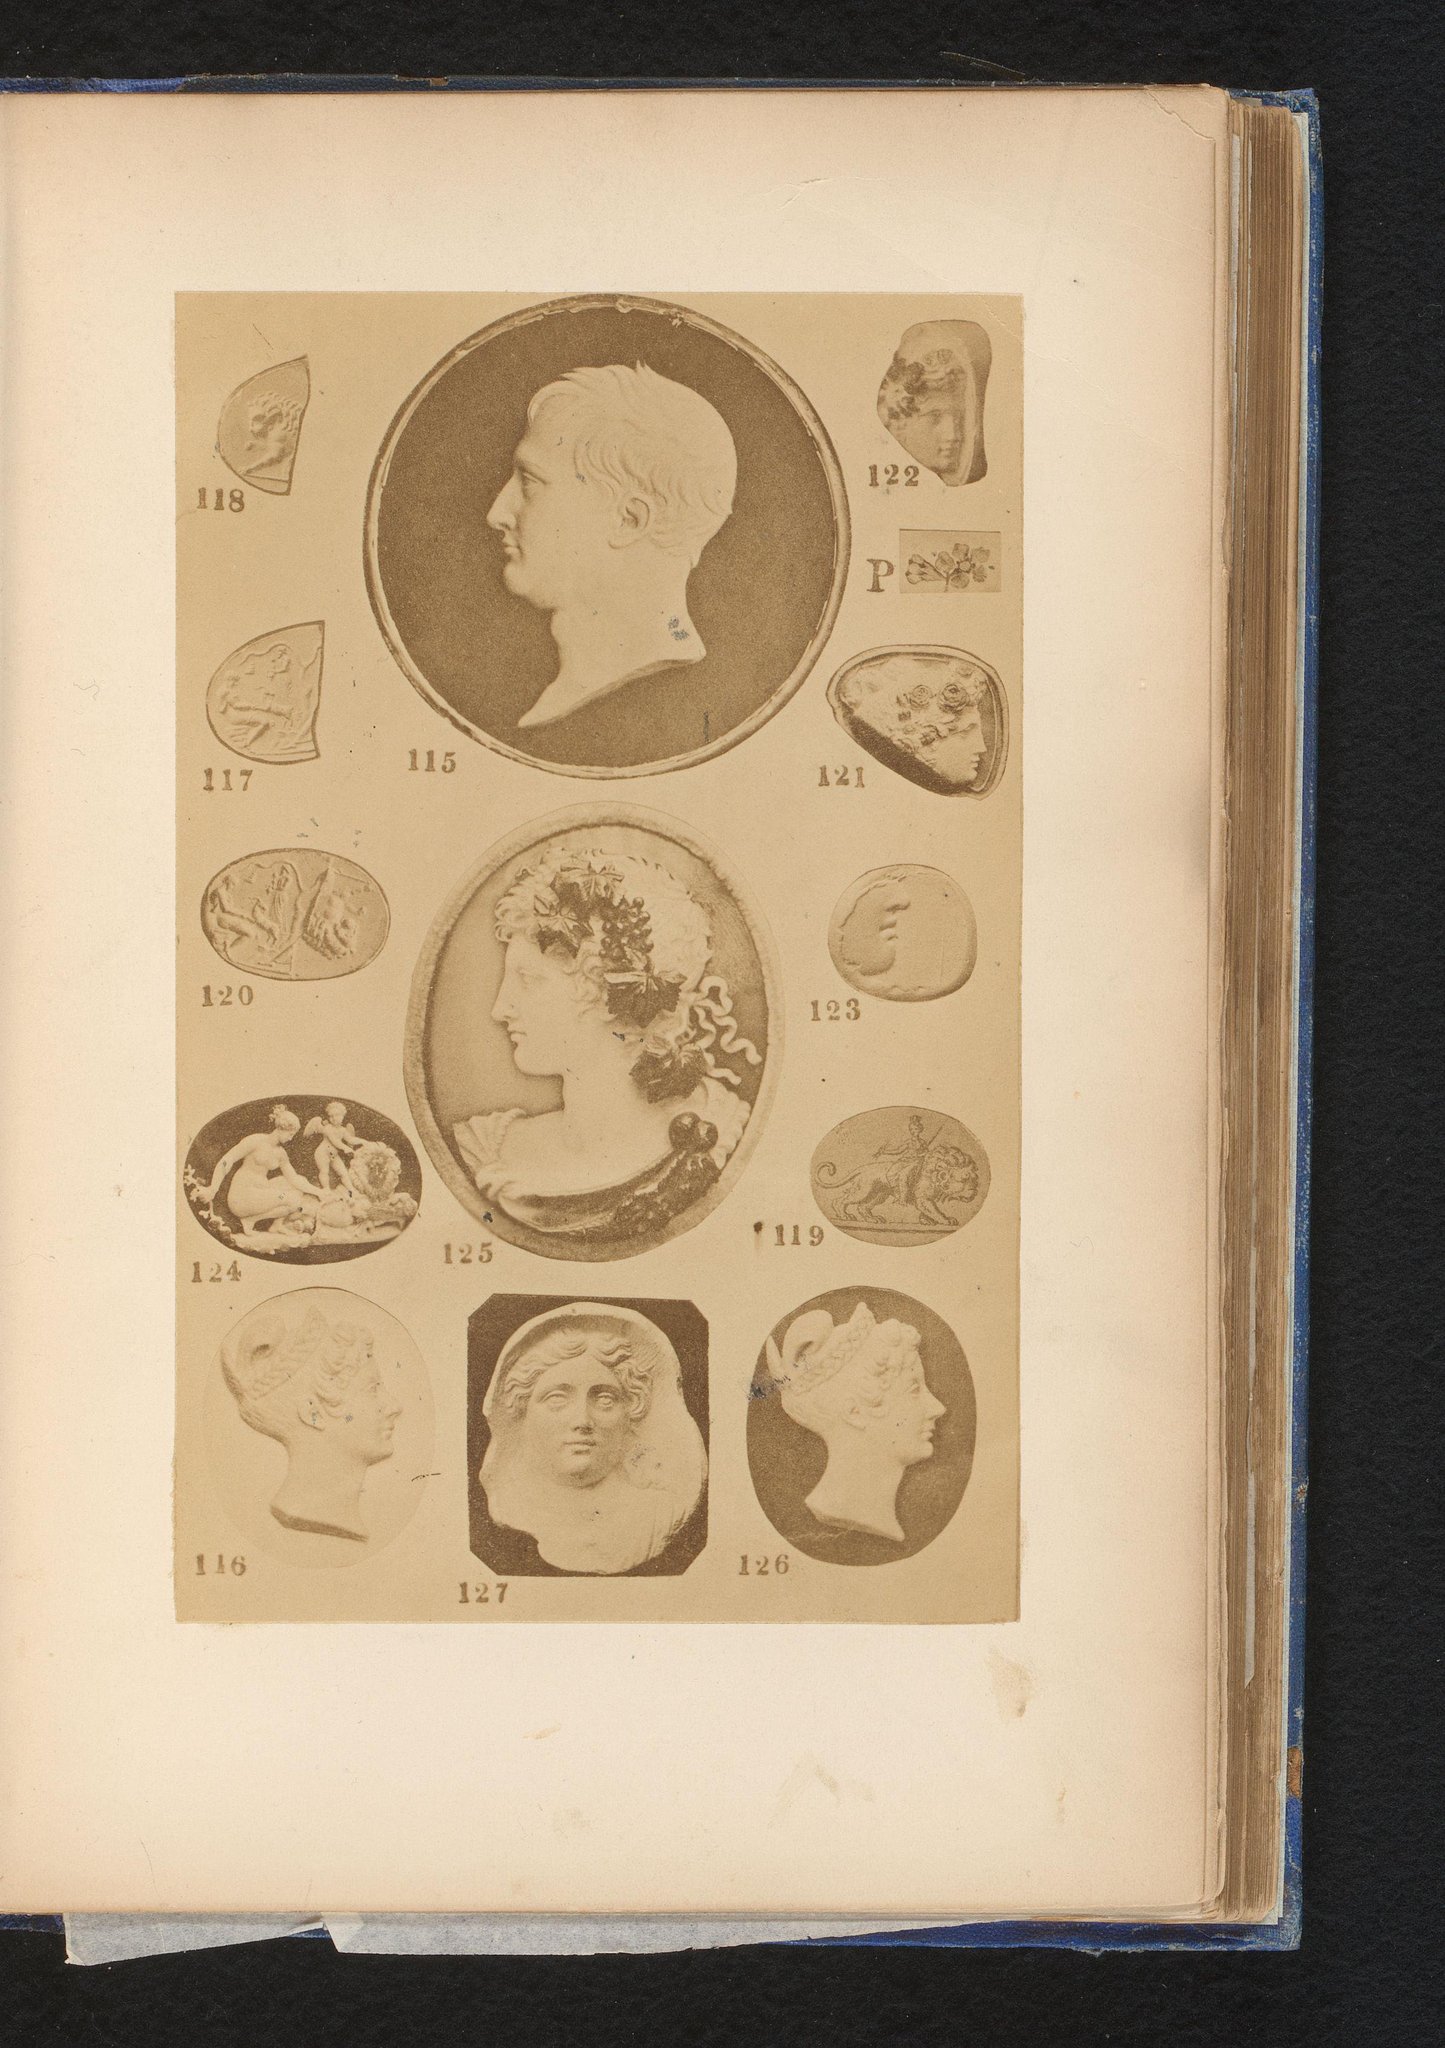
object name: page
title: Veertien reliëfs met portretten en profil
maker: f. cole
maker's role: fotograaf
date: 1862-1867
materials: paper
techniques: albumen print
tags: carving ~ applied arts, historical persons (portraits and scenes from the life) (+ profile portrait), sculpture (+ relief ~ sculpture)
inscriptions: number: ‘115 - 127’